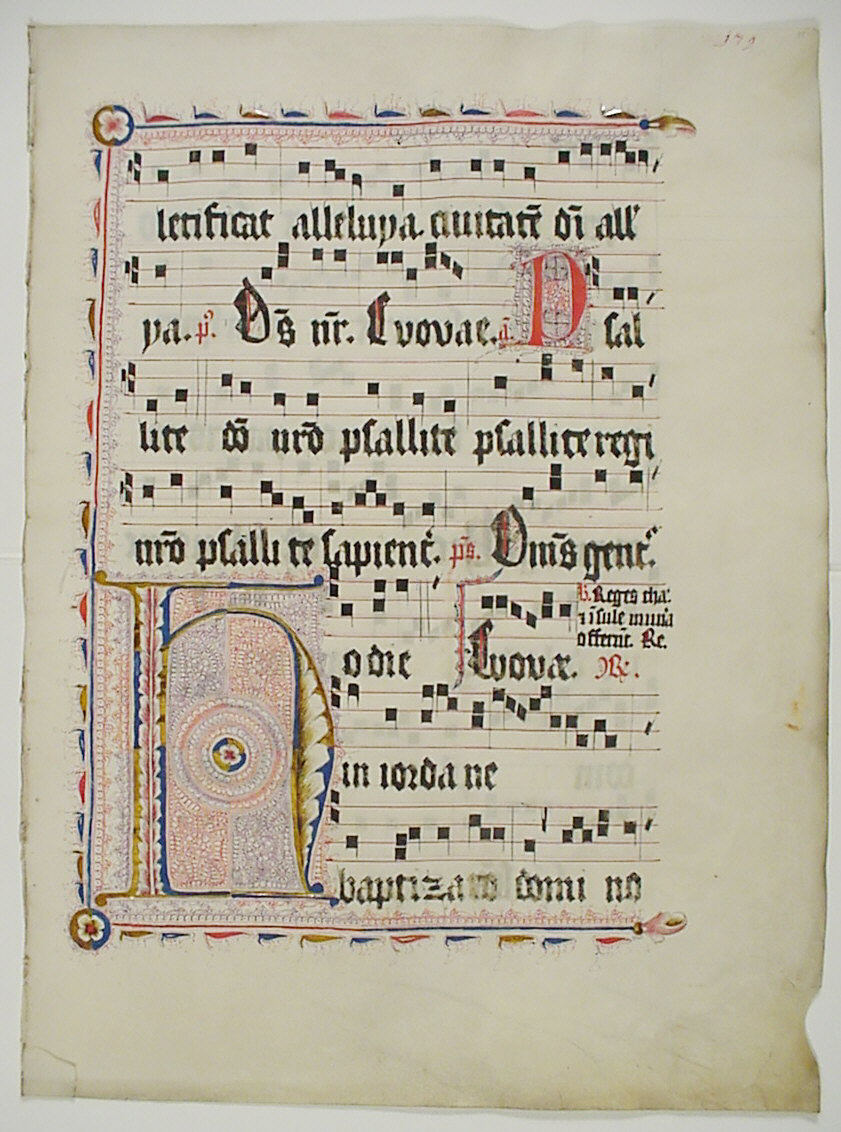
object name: antiphonary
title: Manuscript Leaf with Initial H, from an Antiphonary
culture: german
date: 1426-1450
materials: ink, metal leaf, parchment, paint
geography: germany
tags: music